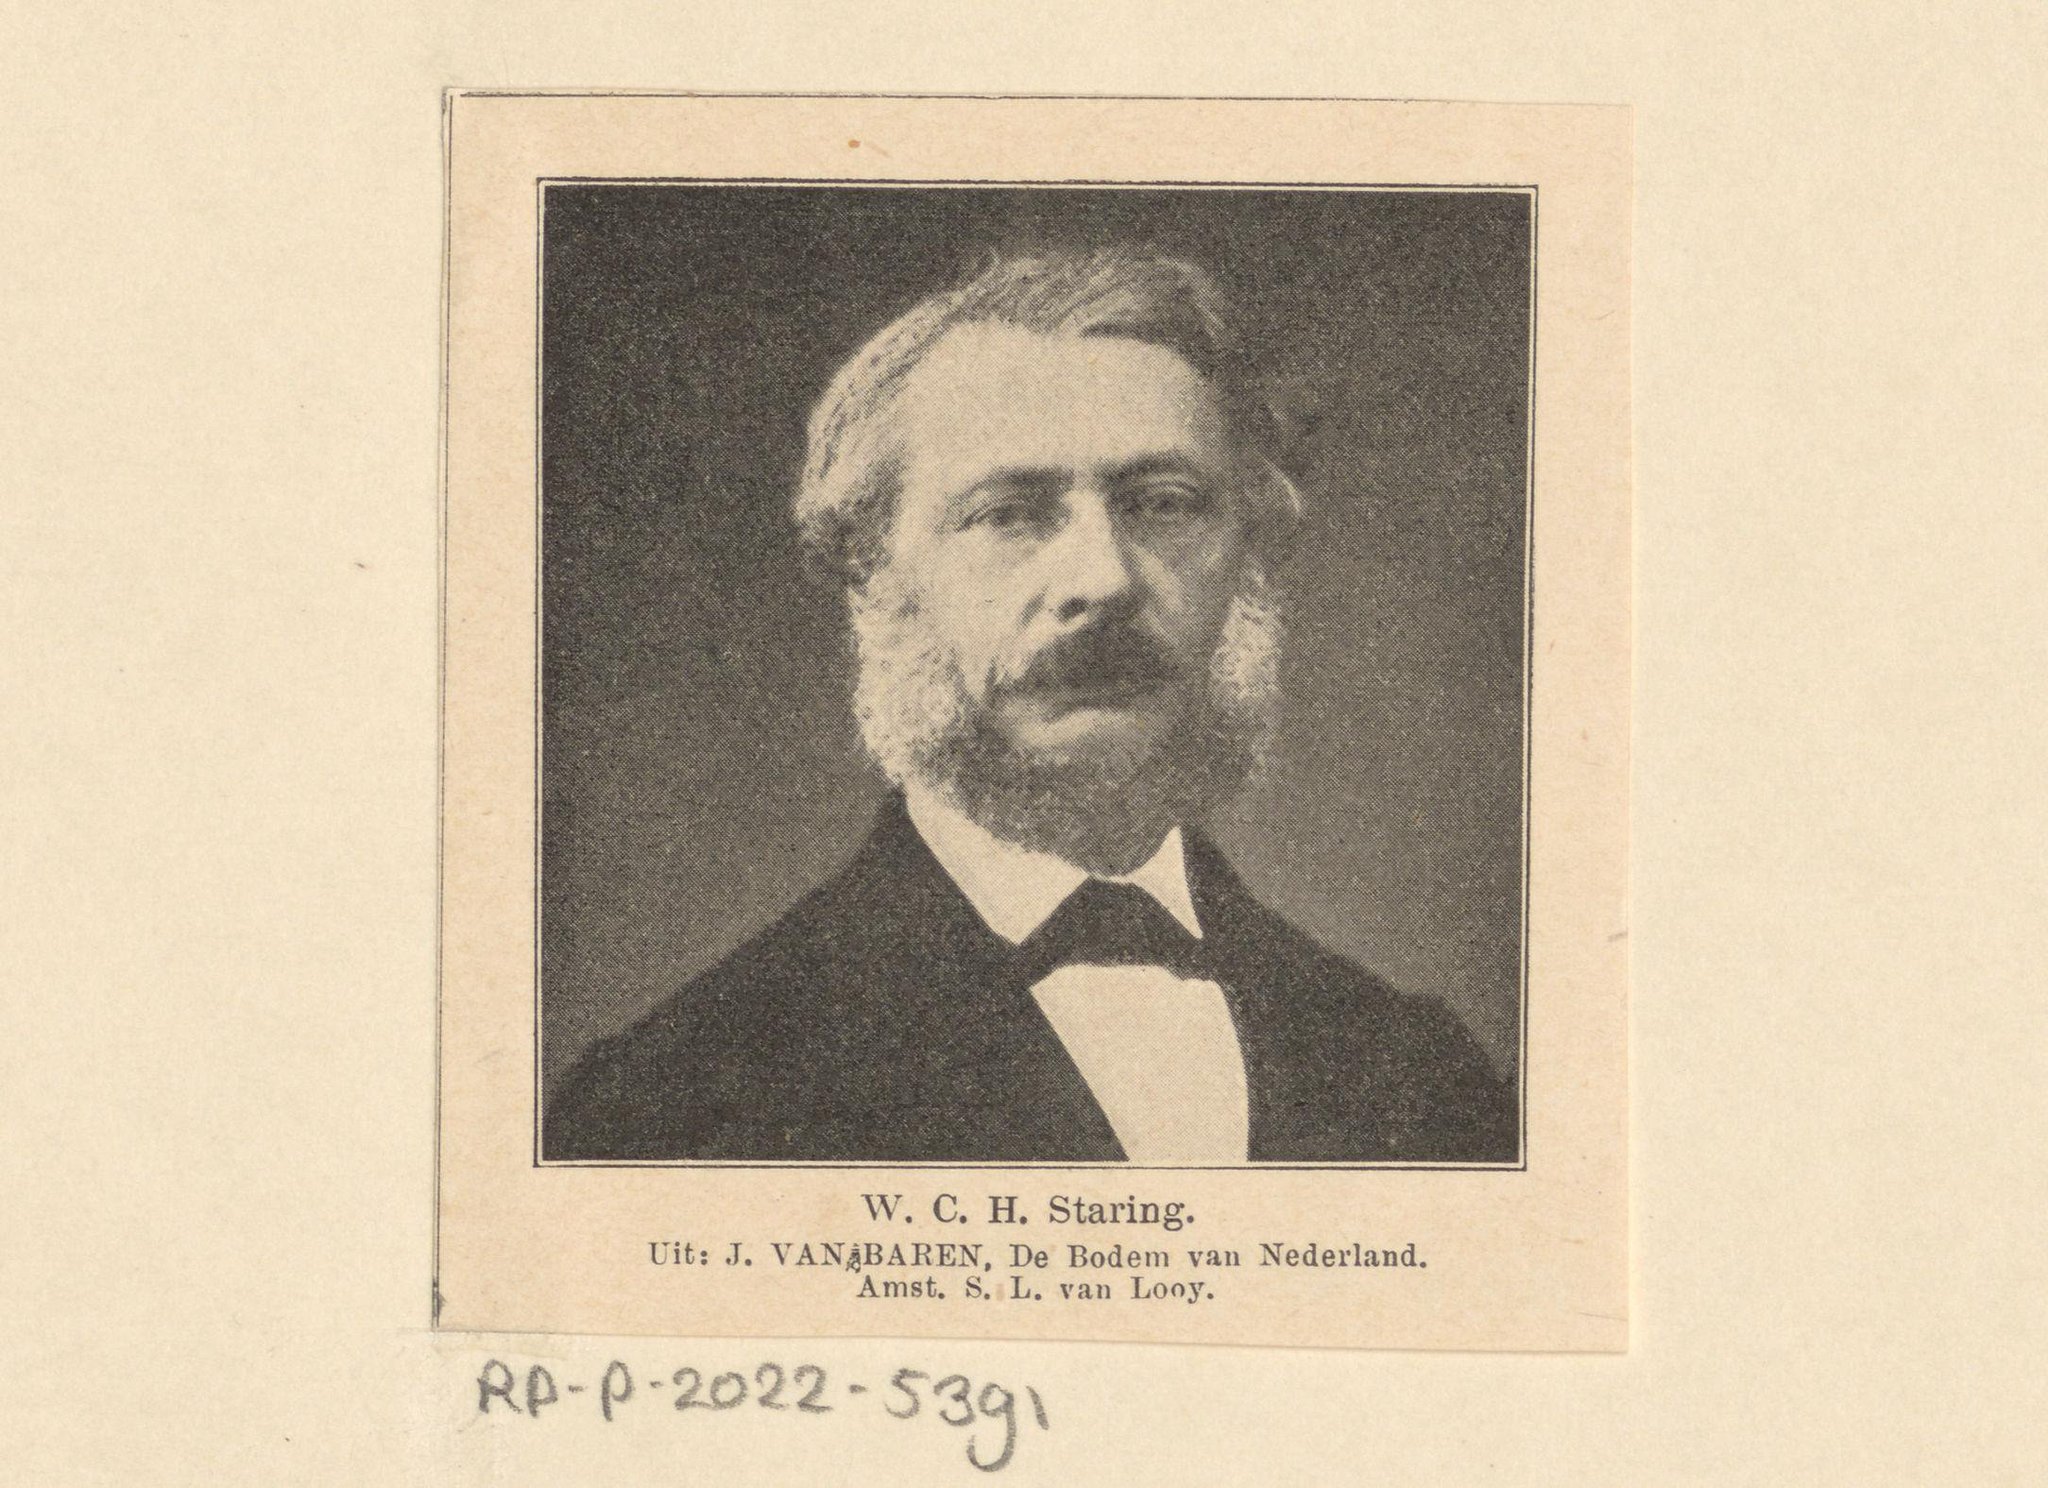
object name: photomechanical print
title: Portret van Winand Staring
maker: Anonymous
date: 1882-1970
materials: paper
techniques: letterpress printing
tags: historical persons, geology (+ portrait of scholar, scientist)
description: Fotomechanische afdruk uit een onbekende publicatie.